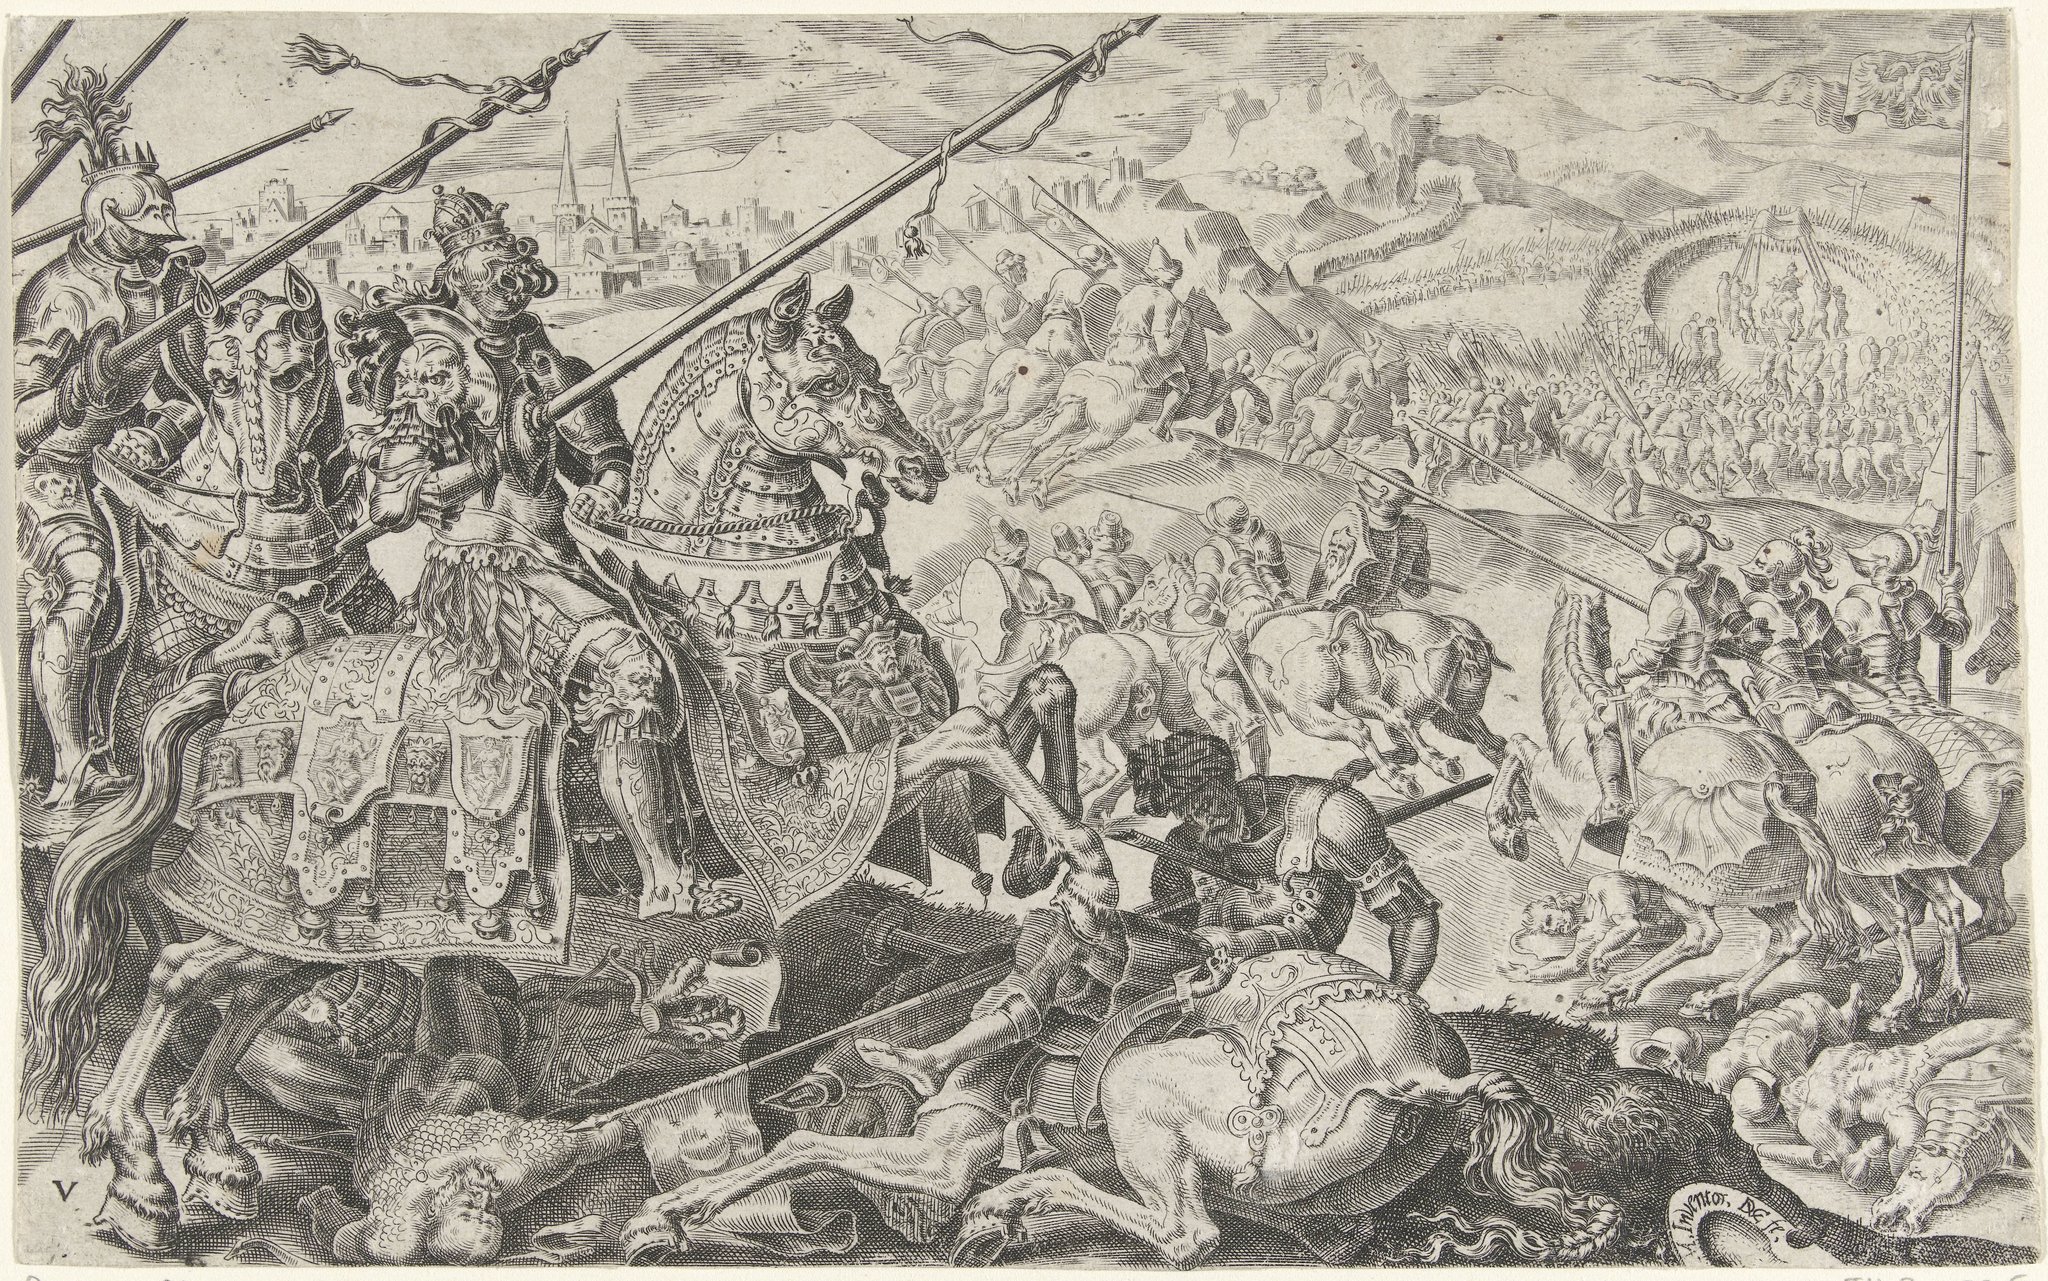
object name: print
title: Divi Caroli. V. imp. opt. max. victoriae, ex multis praecipuae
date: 1555-1556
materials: paper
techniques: engraving, etching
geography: haarlem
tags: ghent, charles v (holy roman emperor and king of spain), vienna, ferdinand i van habsburg (duits keizer)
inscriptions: collector's mark: Lugt 2228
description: Keizer Karel V te paard met achter hem zijn broer Ferdinant van Hongarije. Zijn leger jaagt de Turkse belegeringstroepen op de vlucht die hadden getracht Wenen te veroveren (1529). In de achtergrond rechts sultan Süleyman I die de aftocht blaast. In de achtergrond links de stad Wenen. De prent maakt deel uit van een twaalfdelige serie over de overwinningen van Karel V.